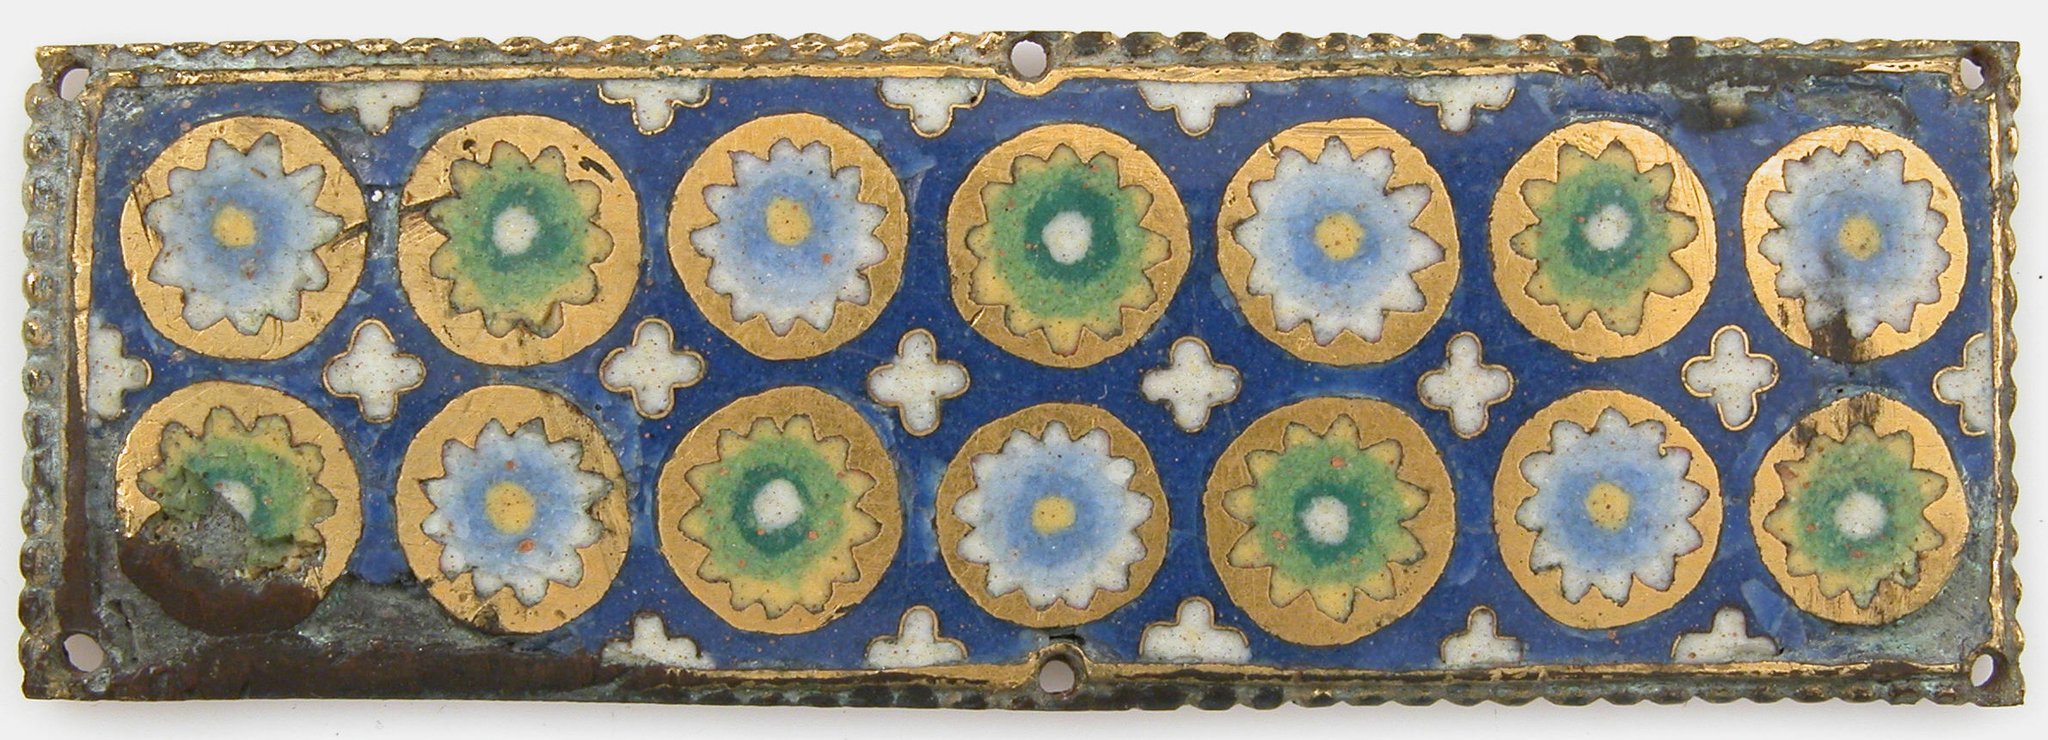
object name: plaque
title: Plaque from a Reliquary Shrine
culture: german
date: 1185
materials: copper alloy, enamel, gilt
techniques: enamel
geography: germany